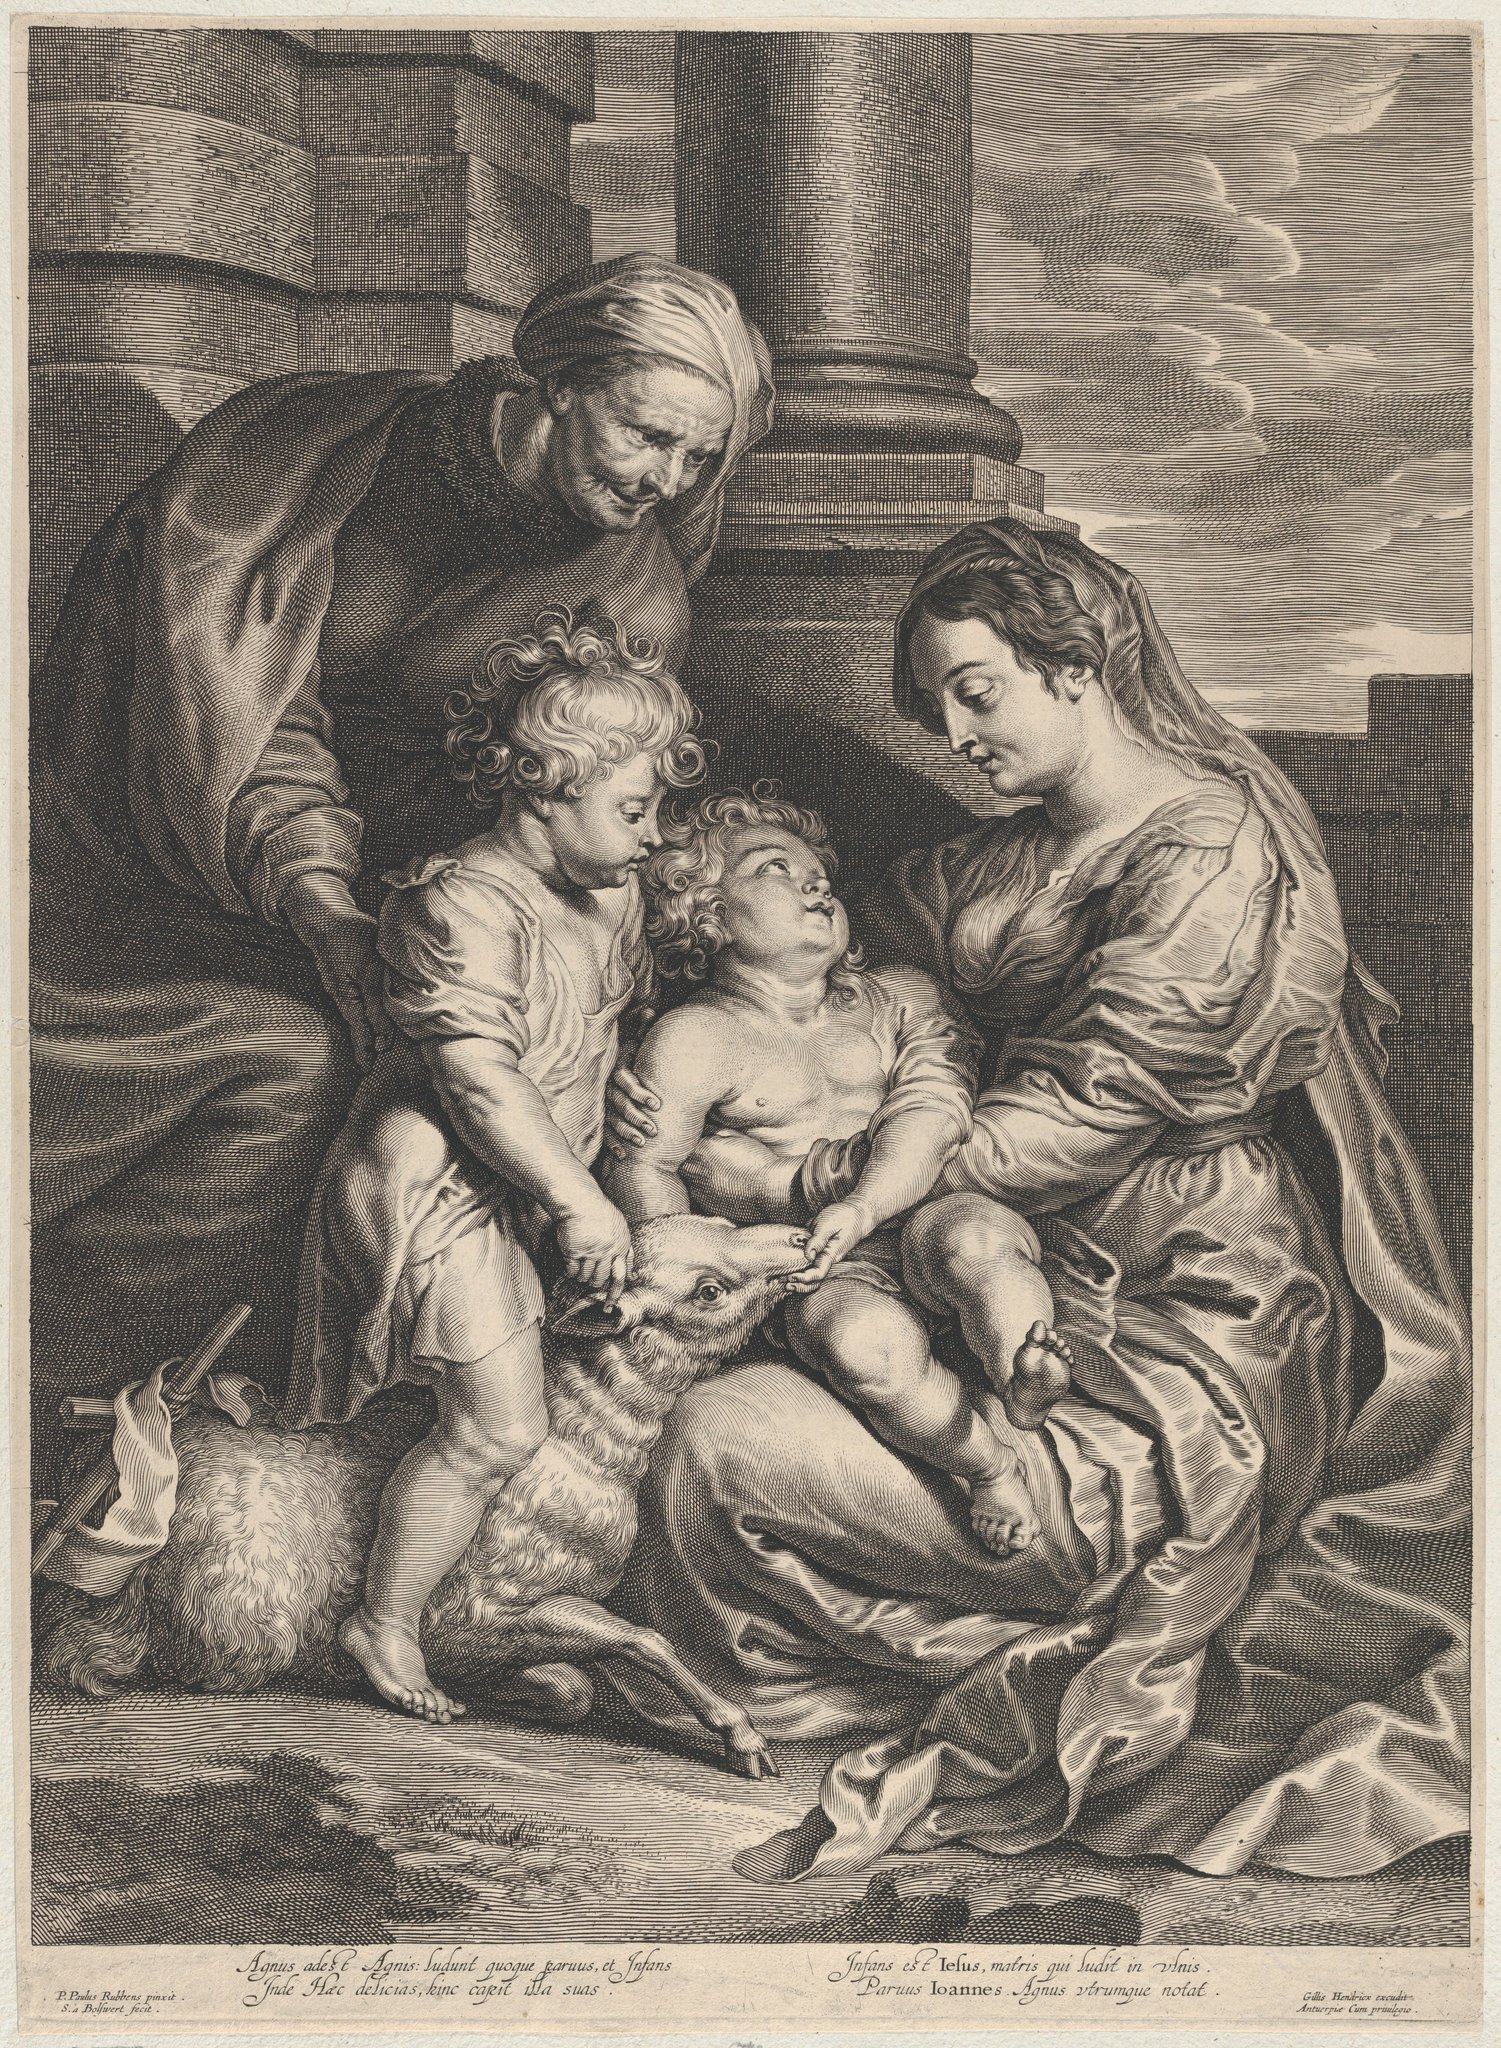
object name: print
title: The Virgin and Christ child with Saint Anne and Saint John the Baptist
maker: schelte adams à bolswert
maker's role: artist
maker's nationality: dutch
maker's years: 1581-1659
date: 1640-1659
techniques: engraving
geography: antwerp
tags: saint anne,saint john the baptist,virgin mary,jesus